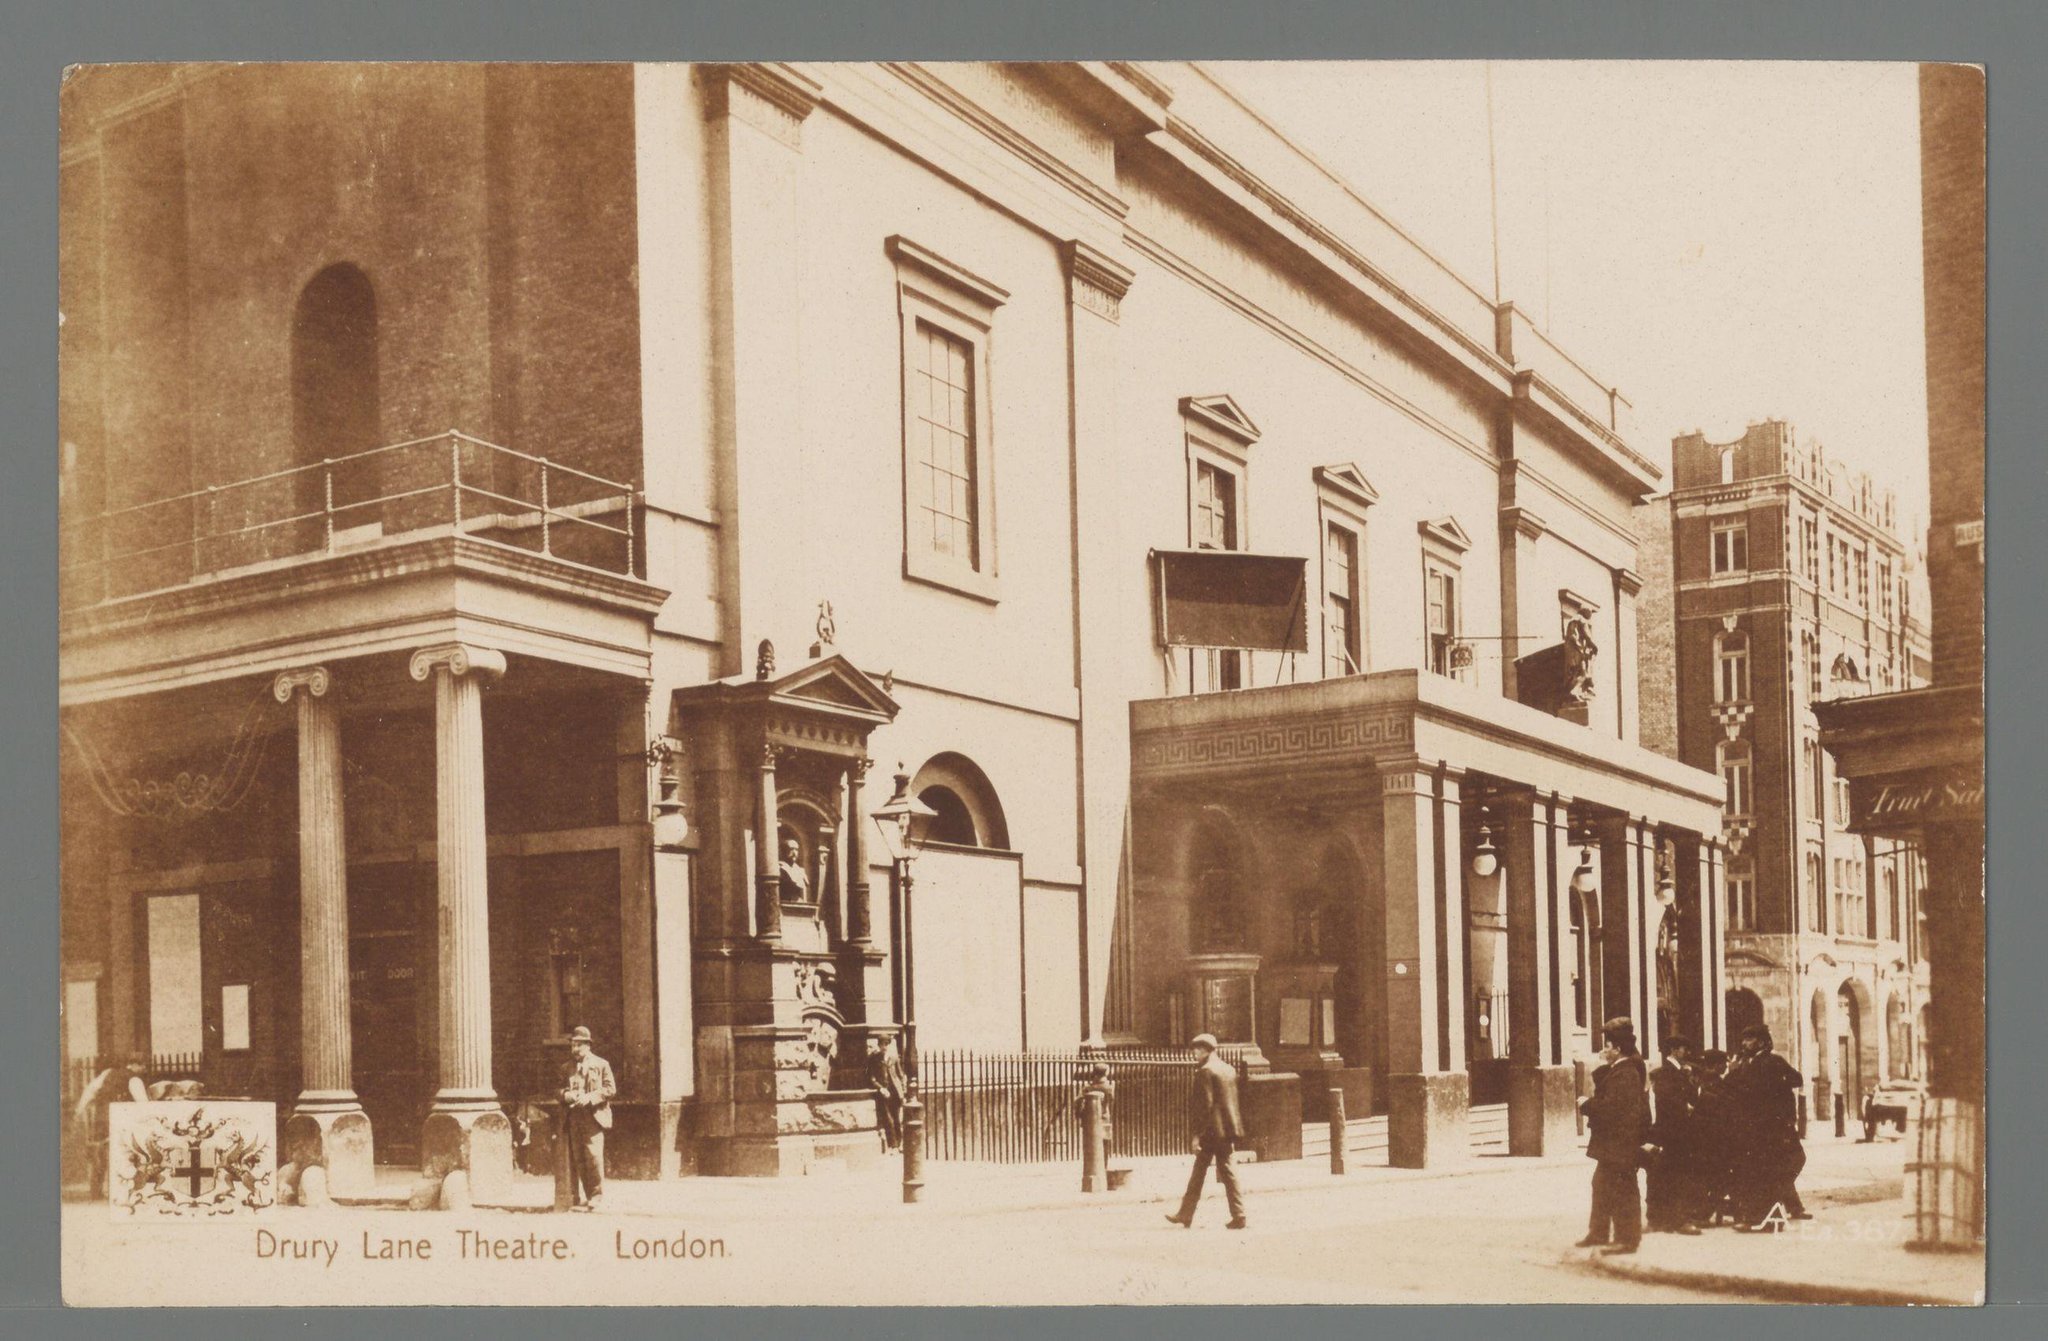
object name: photograph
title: Drury Lane Theatre. London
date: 1902-1940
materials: paper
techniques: gelatin silver print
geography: saxony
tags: coat of arms (as symbol of the state, etc.), theatre (building)